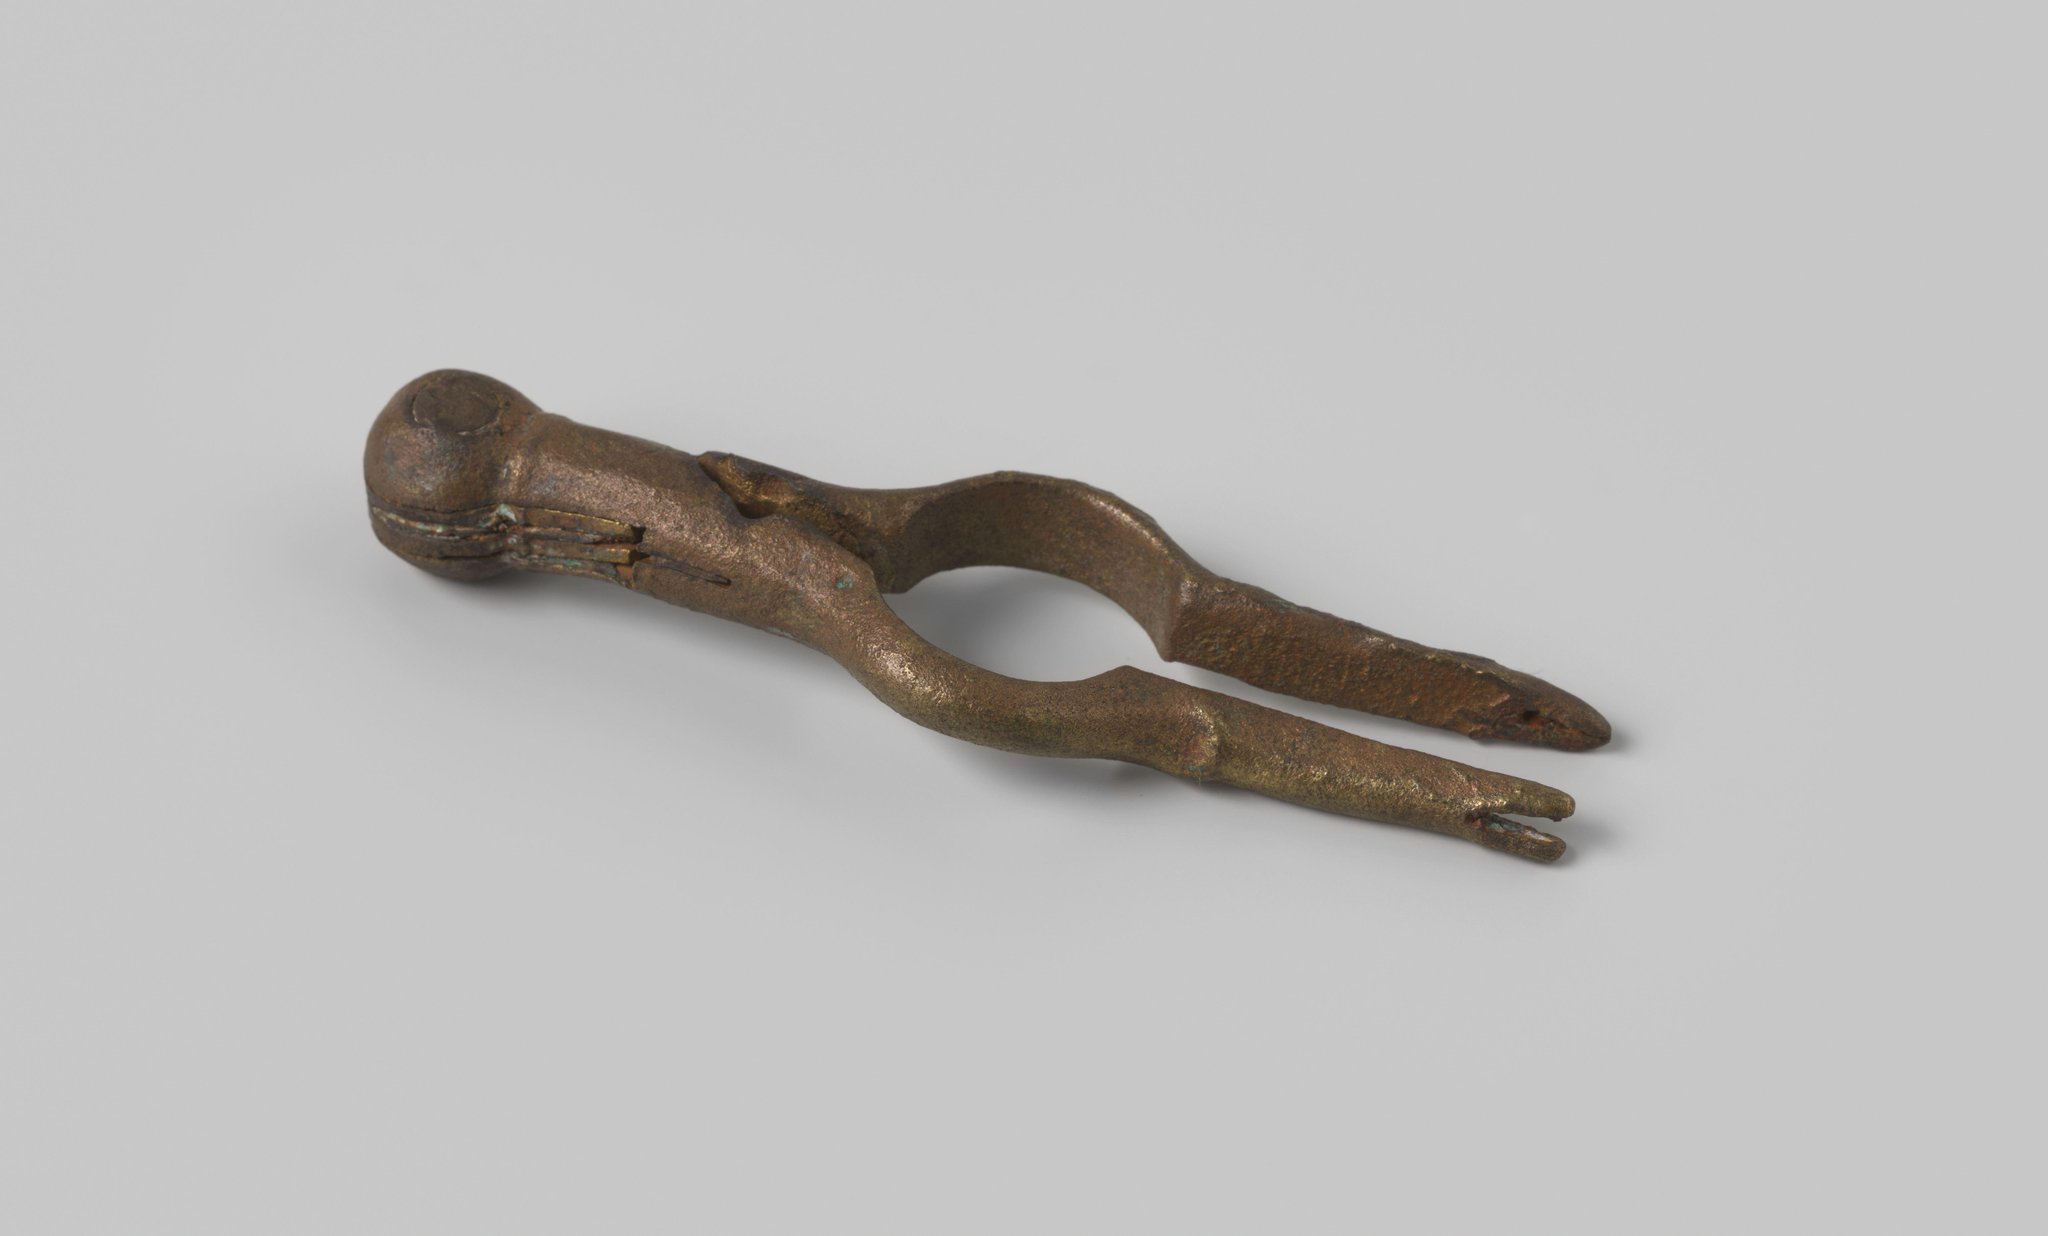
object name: divider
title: Steekpasser uit het wrak van de Oost-Indiëvaarder Hollandia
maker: Anonymous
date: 1700-1743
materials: copper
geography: netherlands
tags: verenigde oostindische compagnie, hollandia (schip), annet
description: Divider; eroded: consisting of 2 legs, semicircular in section, straight with semicircular bulge, interlocking at end, hinge ball-shaped, hexagonal faceted, double bladed.